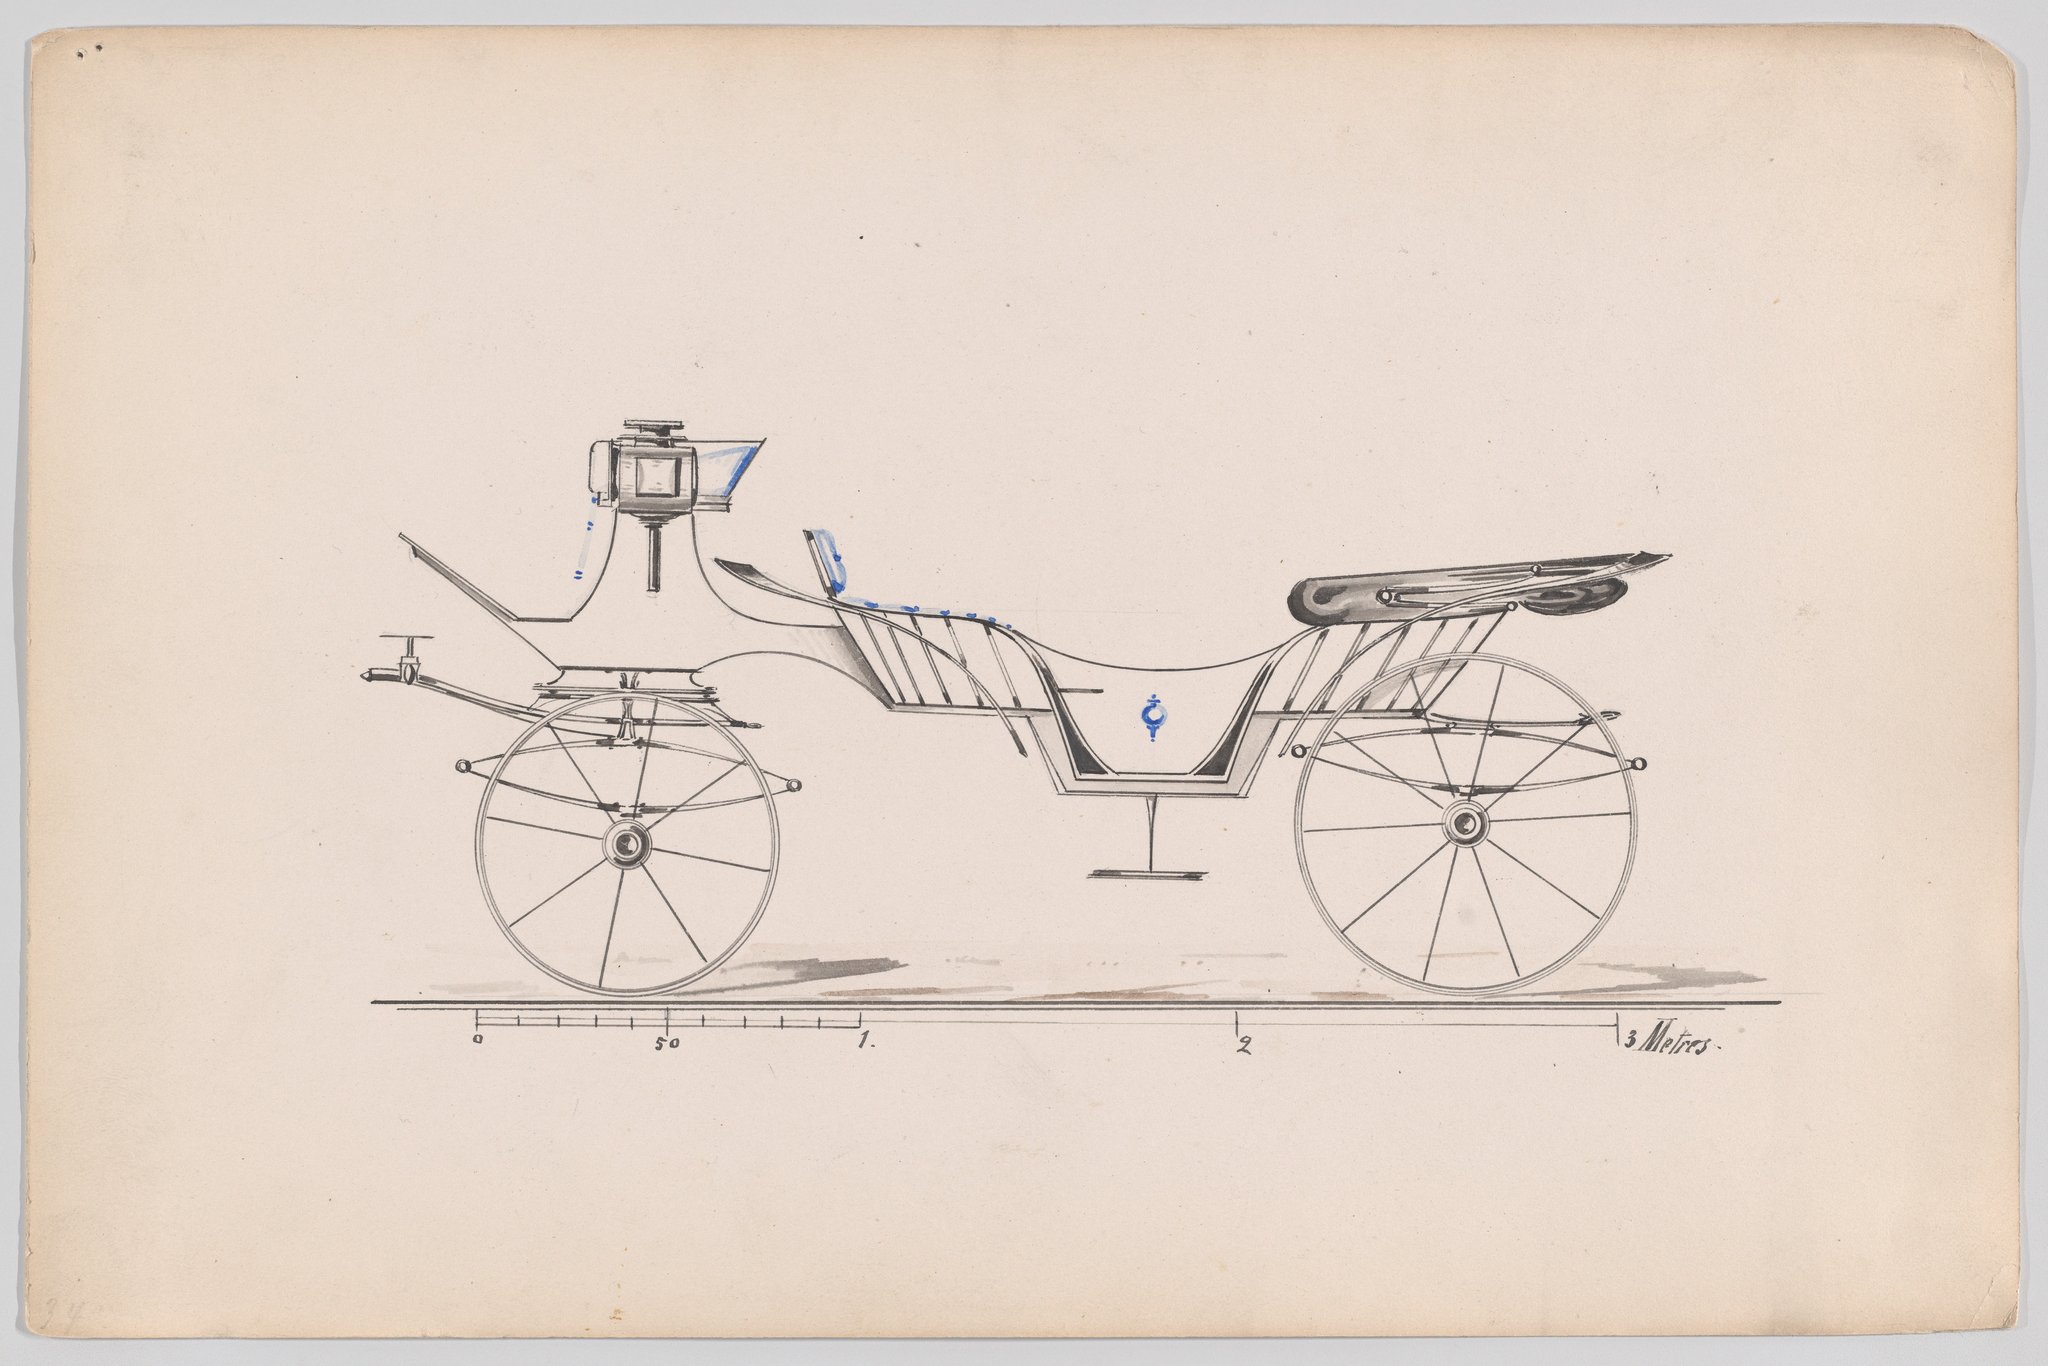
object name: drawing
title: Design for Drop Center Vis-à-Vis (French?)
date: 1880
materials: gouache, ink, watercolor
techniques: pen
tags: carriages